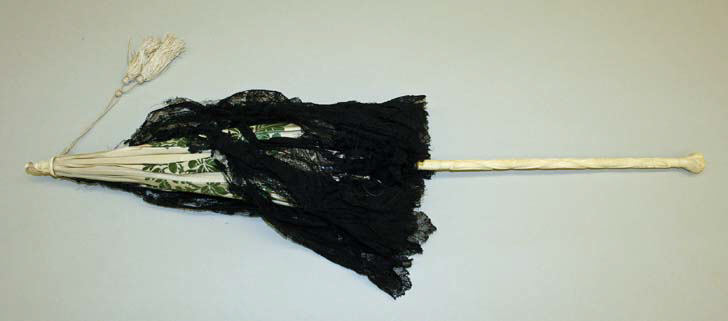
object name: parasol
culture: american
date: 1858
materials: cotton, silk